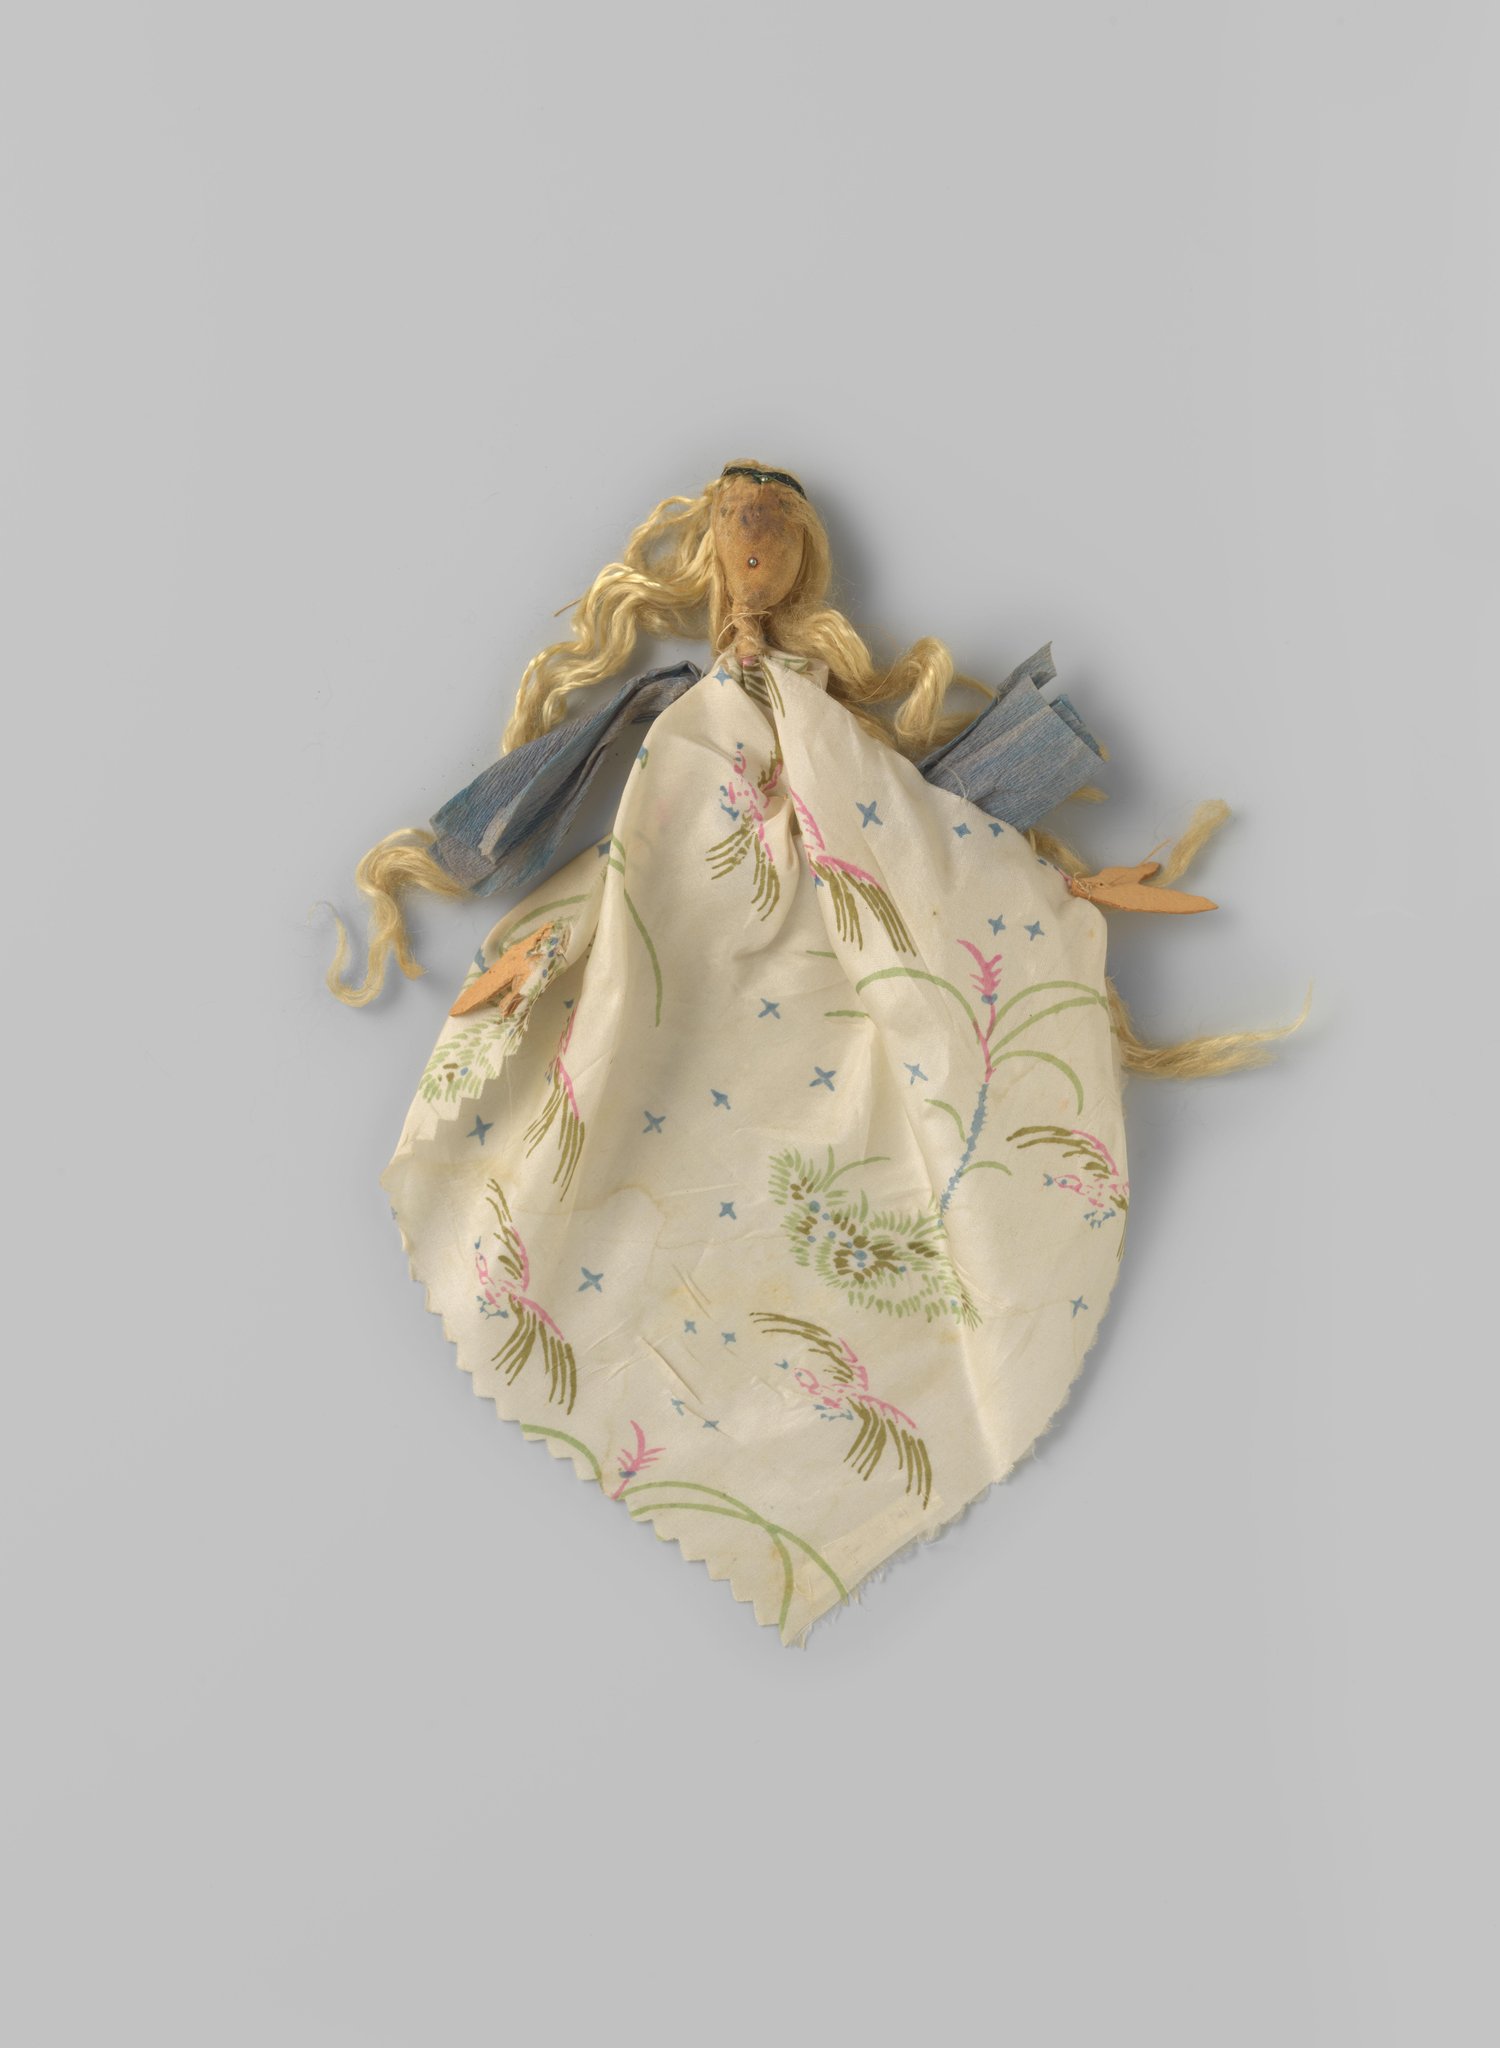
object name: marionette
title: Marionet, bestaande uit hoofd van klei en lichaam van zijde met handen van karton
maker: ada helena hondius-crone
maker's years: 1893-1996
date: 1920-1930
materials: cardboard, clay, paper, glass, silk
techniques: manufacturing, firing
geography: amsterdam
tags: amsterdam, voorschoten, ada helena hondius-crone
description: Marionet, bestaande uit hoofd van klei en lichaam van zijde met handen van karton. Het gezicht is gemodelleerd met een vooruitstekende neus en een kin. De ogen zijn kleine geverfde puntjes en in de ronde rode mond een zilverkleurige kopspeld. Lang losvallend haar van gele floszijde, dat op het hoofd bijeen wordt gehouden door een smal zwart hoofdbandje. Strik van blauw crêpe papier. Lichaam van een staal zijde oplopend met een wit fond waarop een fantasie motief in groem, blauw en roze. Aan een kant voorzien van een kartelrand.